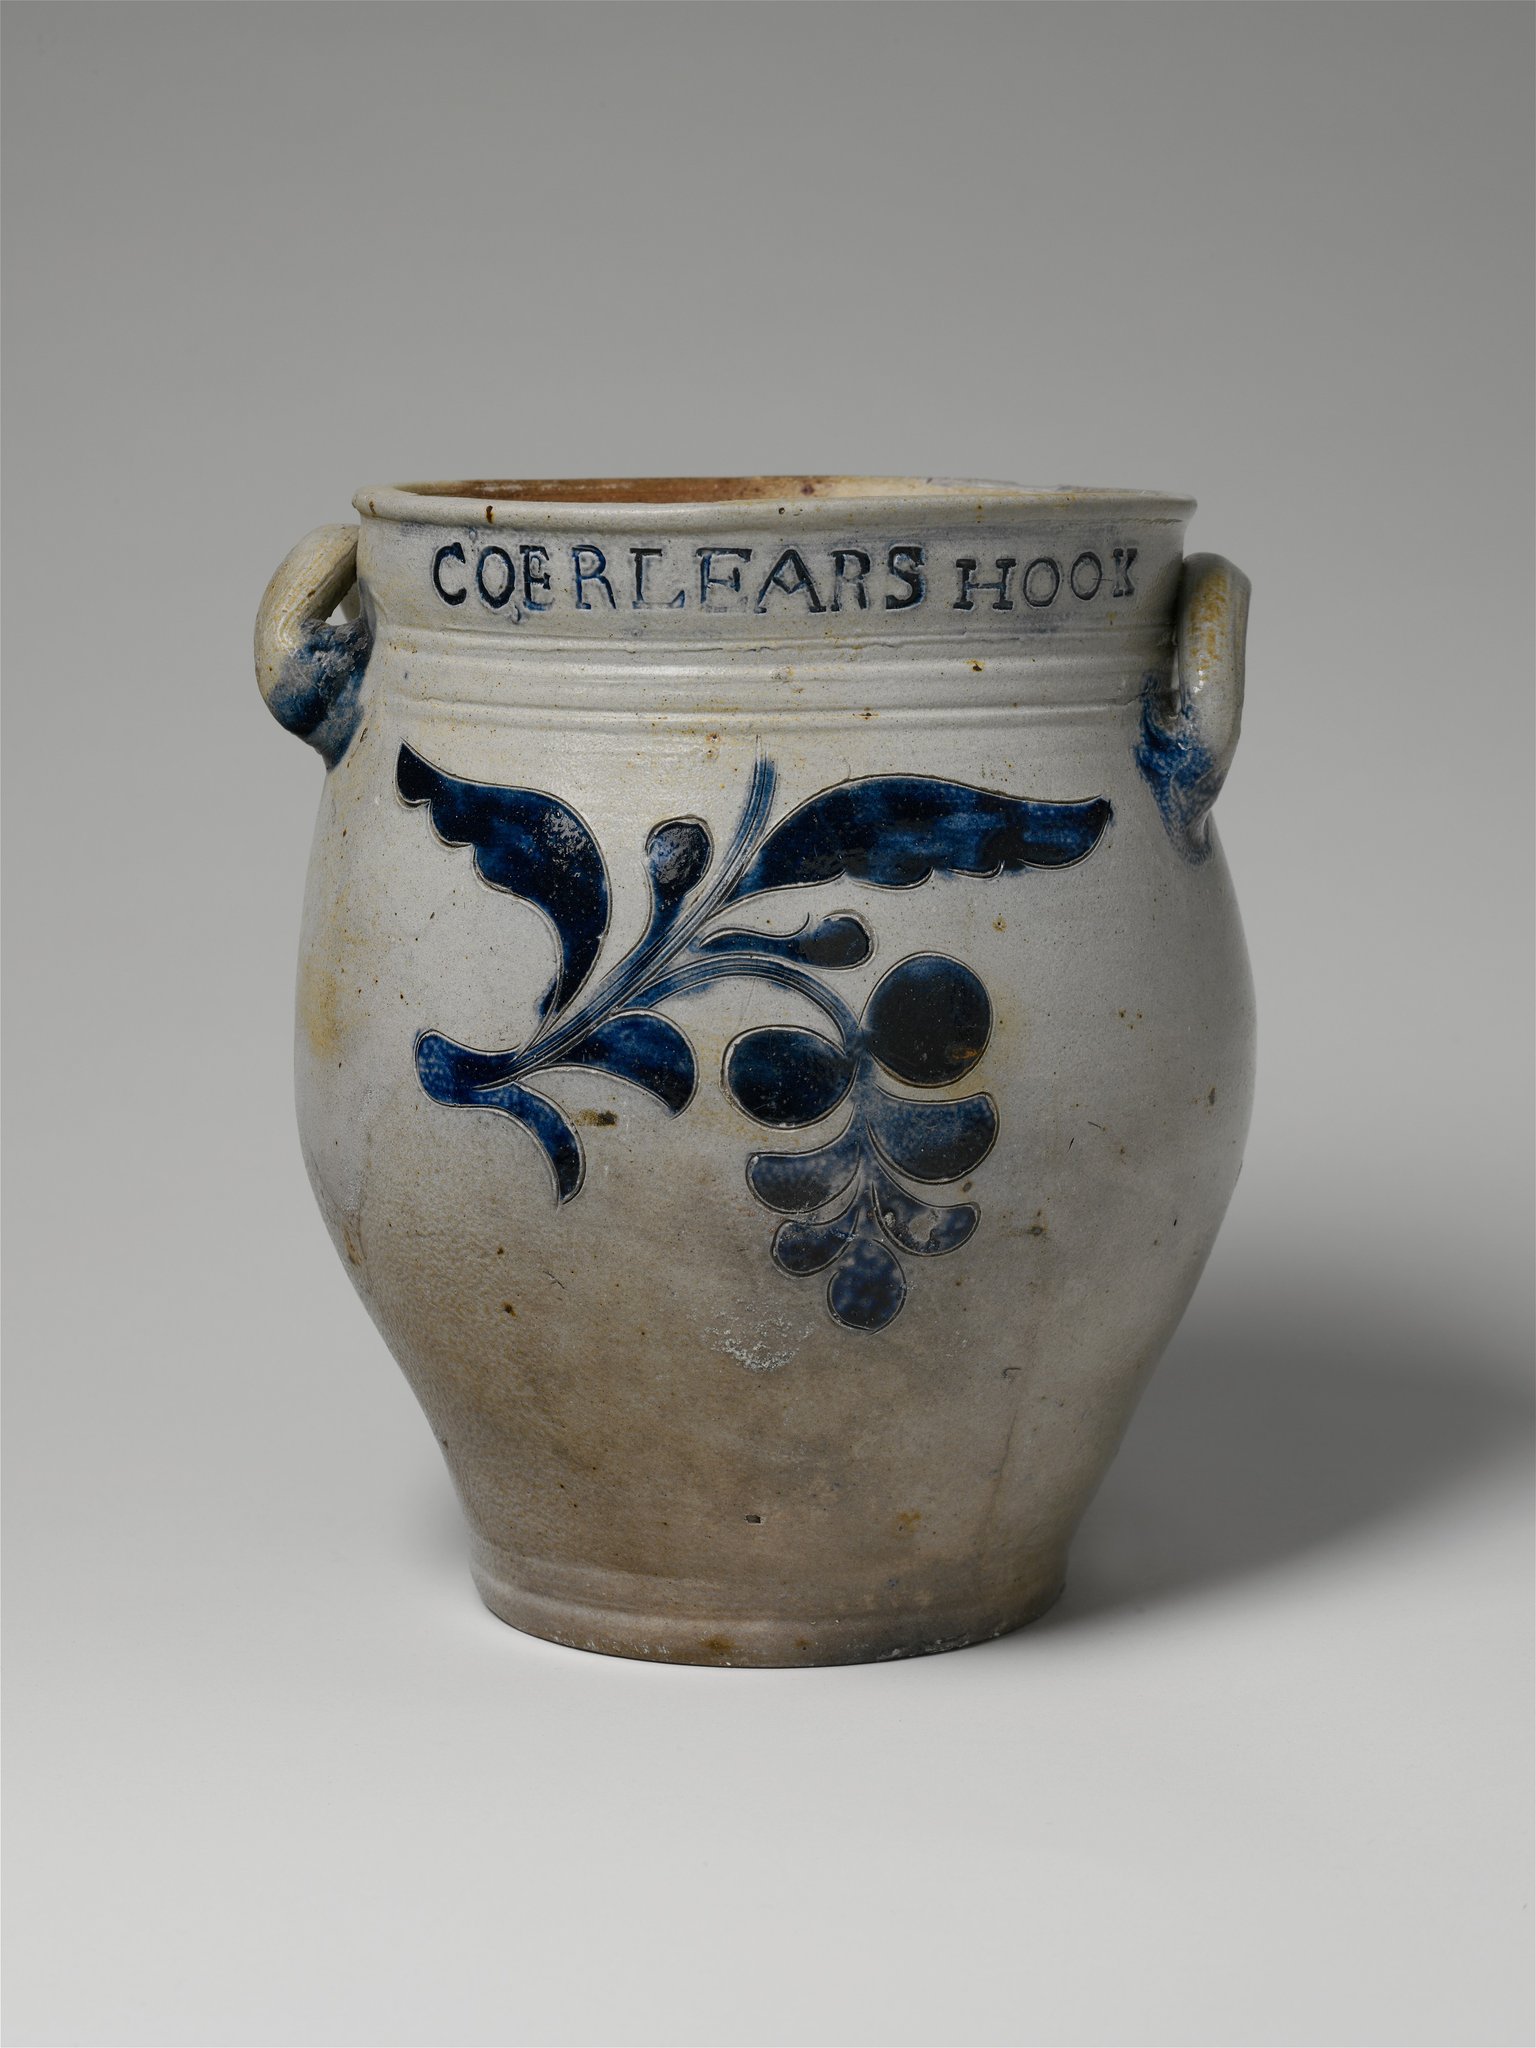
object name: jar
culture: american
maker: thomas w. commeraw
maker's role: maker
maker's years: 1796-1819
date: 1796-1819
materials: stoneware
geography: united states